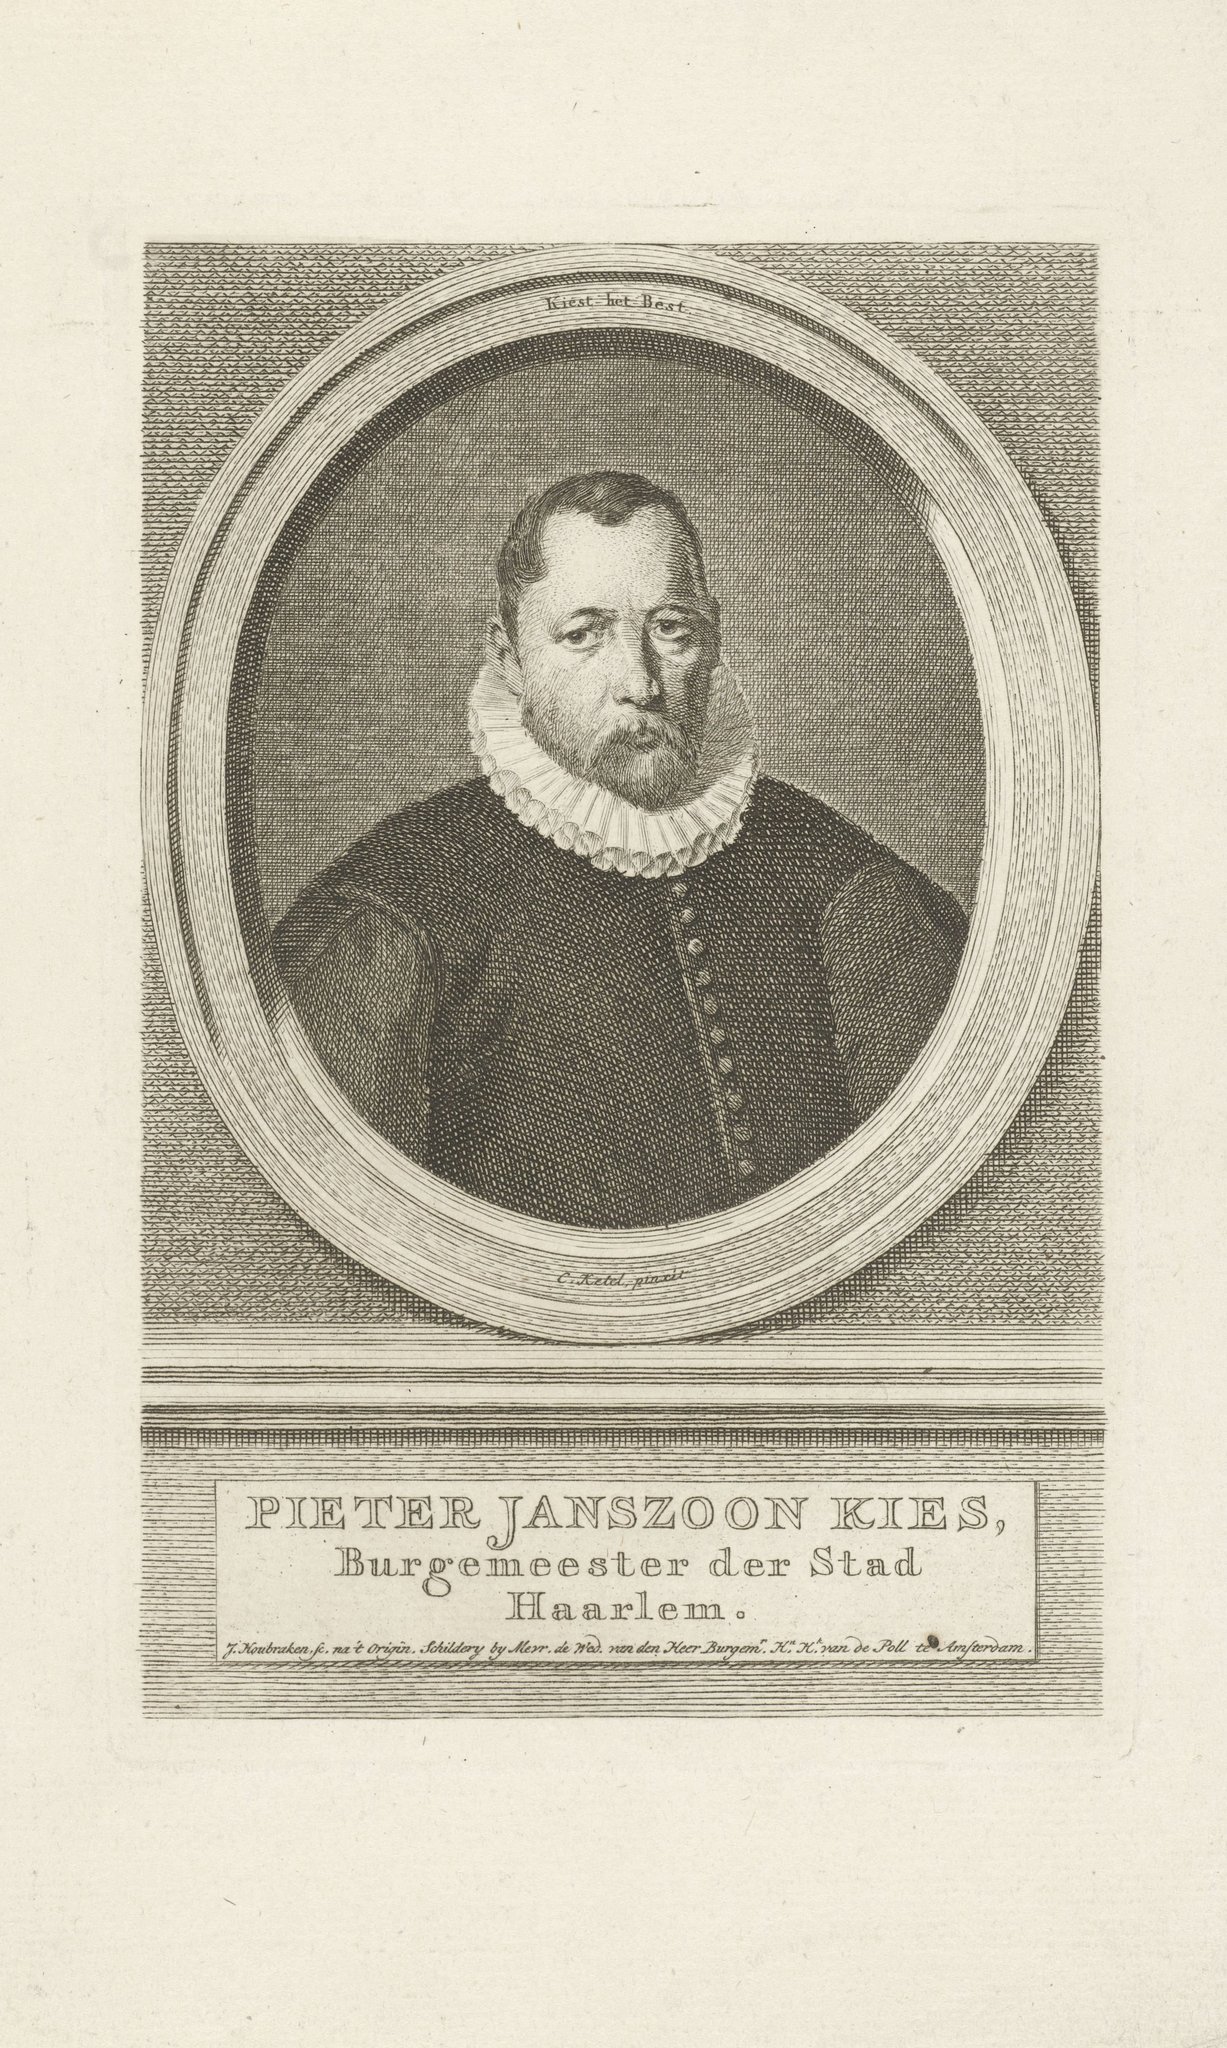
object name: print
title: Portret van Pieter Janszoon Kies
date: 1749-1780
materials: paper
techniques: engraving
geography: amsterdam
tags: mayor, historical persons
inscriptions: collector's mark: Lugt 2228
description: Deze prent is oorspronkelijk bedoeld als aanvulling op Jan Wagenaars ‘Vaderlandsche historie’* en was zo vanaf 1796 verkrijgbaar bij Johannes Allart te Amsterdam. Voor de advertentie waarin Allart de 60 portretten en 7 platen, allen gegraveerd door Houbraken, ter aanvulling op Wagenaars ‘Vaderlandsche historie’ aanbiedt, zie RP-P-OB-77.766. *Van dit werk zijn in de achttiende eeuw meerdere uitgaves verschenen, zoals: Wagenaar, Jan. Vaderlandsche historie, vervattende de geschiedenissen der Vereenigde Nederlanden (…). 21 delen. Amsterdam: Isaak Tirion, 1749-1759. Wagenaar, Jan. Vaderlandsche historie, vervattende de geschiedenissen der nu Vereenigde Nederlanden (…). 21 delen. Amsterdam: weduwe Isaak Tirion, 1770. Wagenaar, Jan. Vaderlandsche historie, vervattende de geschiedenissen der nu Vereenigde Nederlanden (…). 21 delen. Amsterdam, Leiden, Dordrecht en Harlingen: P. Schouten e.a., 1782. Wagenaar, Jan. Vaderlandsche historie, vervattende de geschiedenissen der nu Vereenigde Nederlanden (…). 21 delen. Amsterdam: Johannes Allart, 1790-1796.